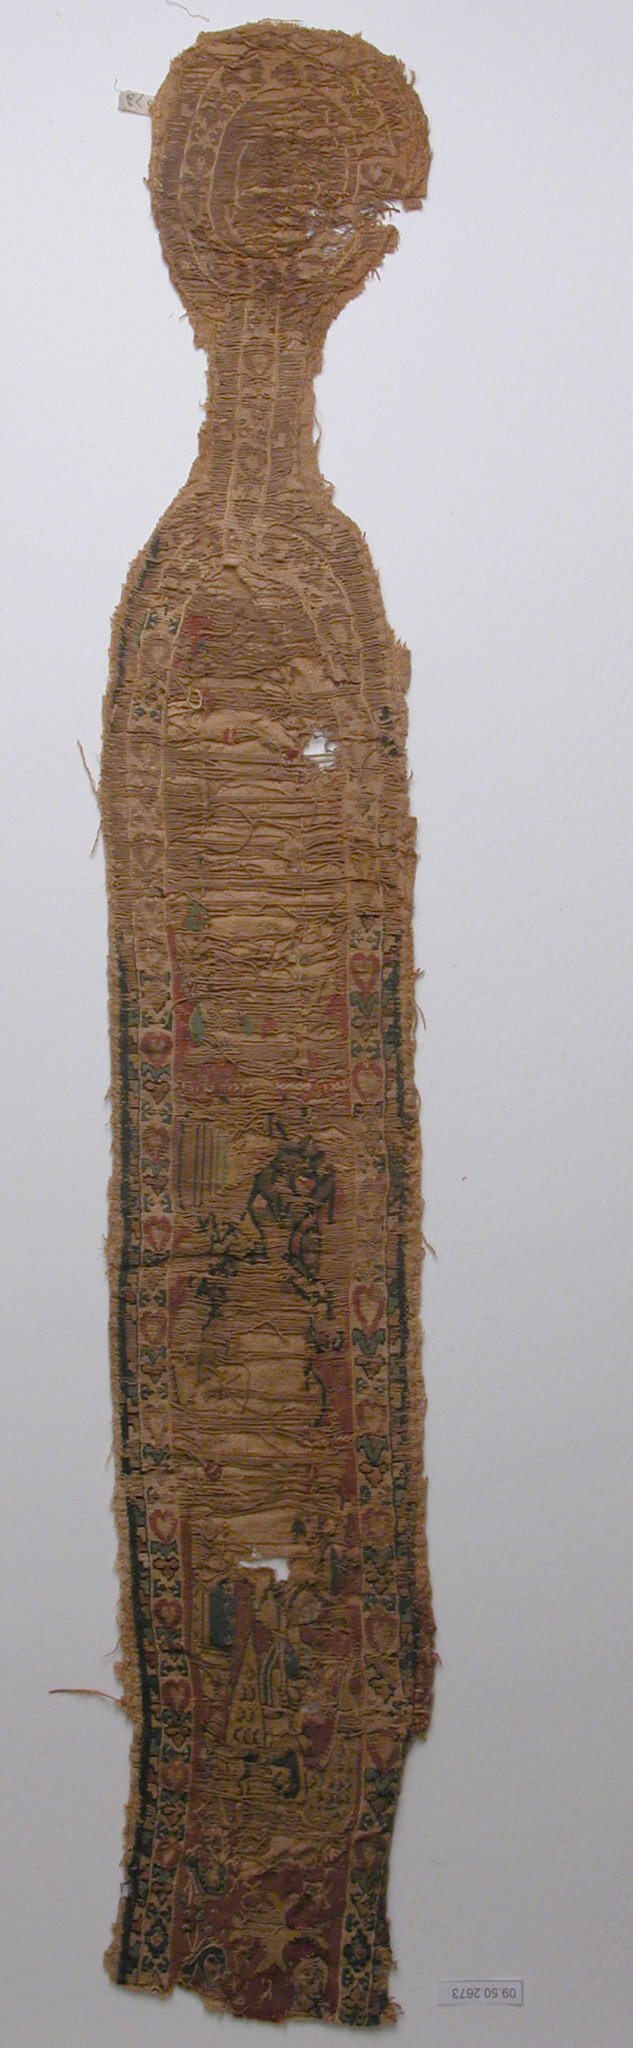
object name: shoulder band fragment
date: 501-800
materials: linen, wool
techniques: weave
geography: egypt